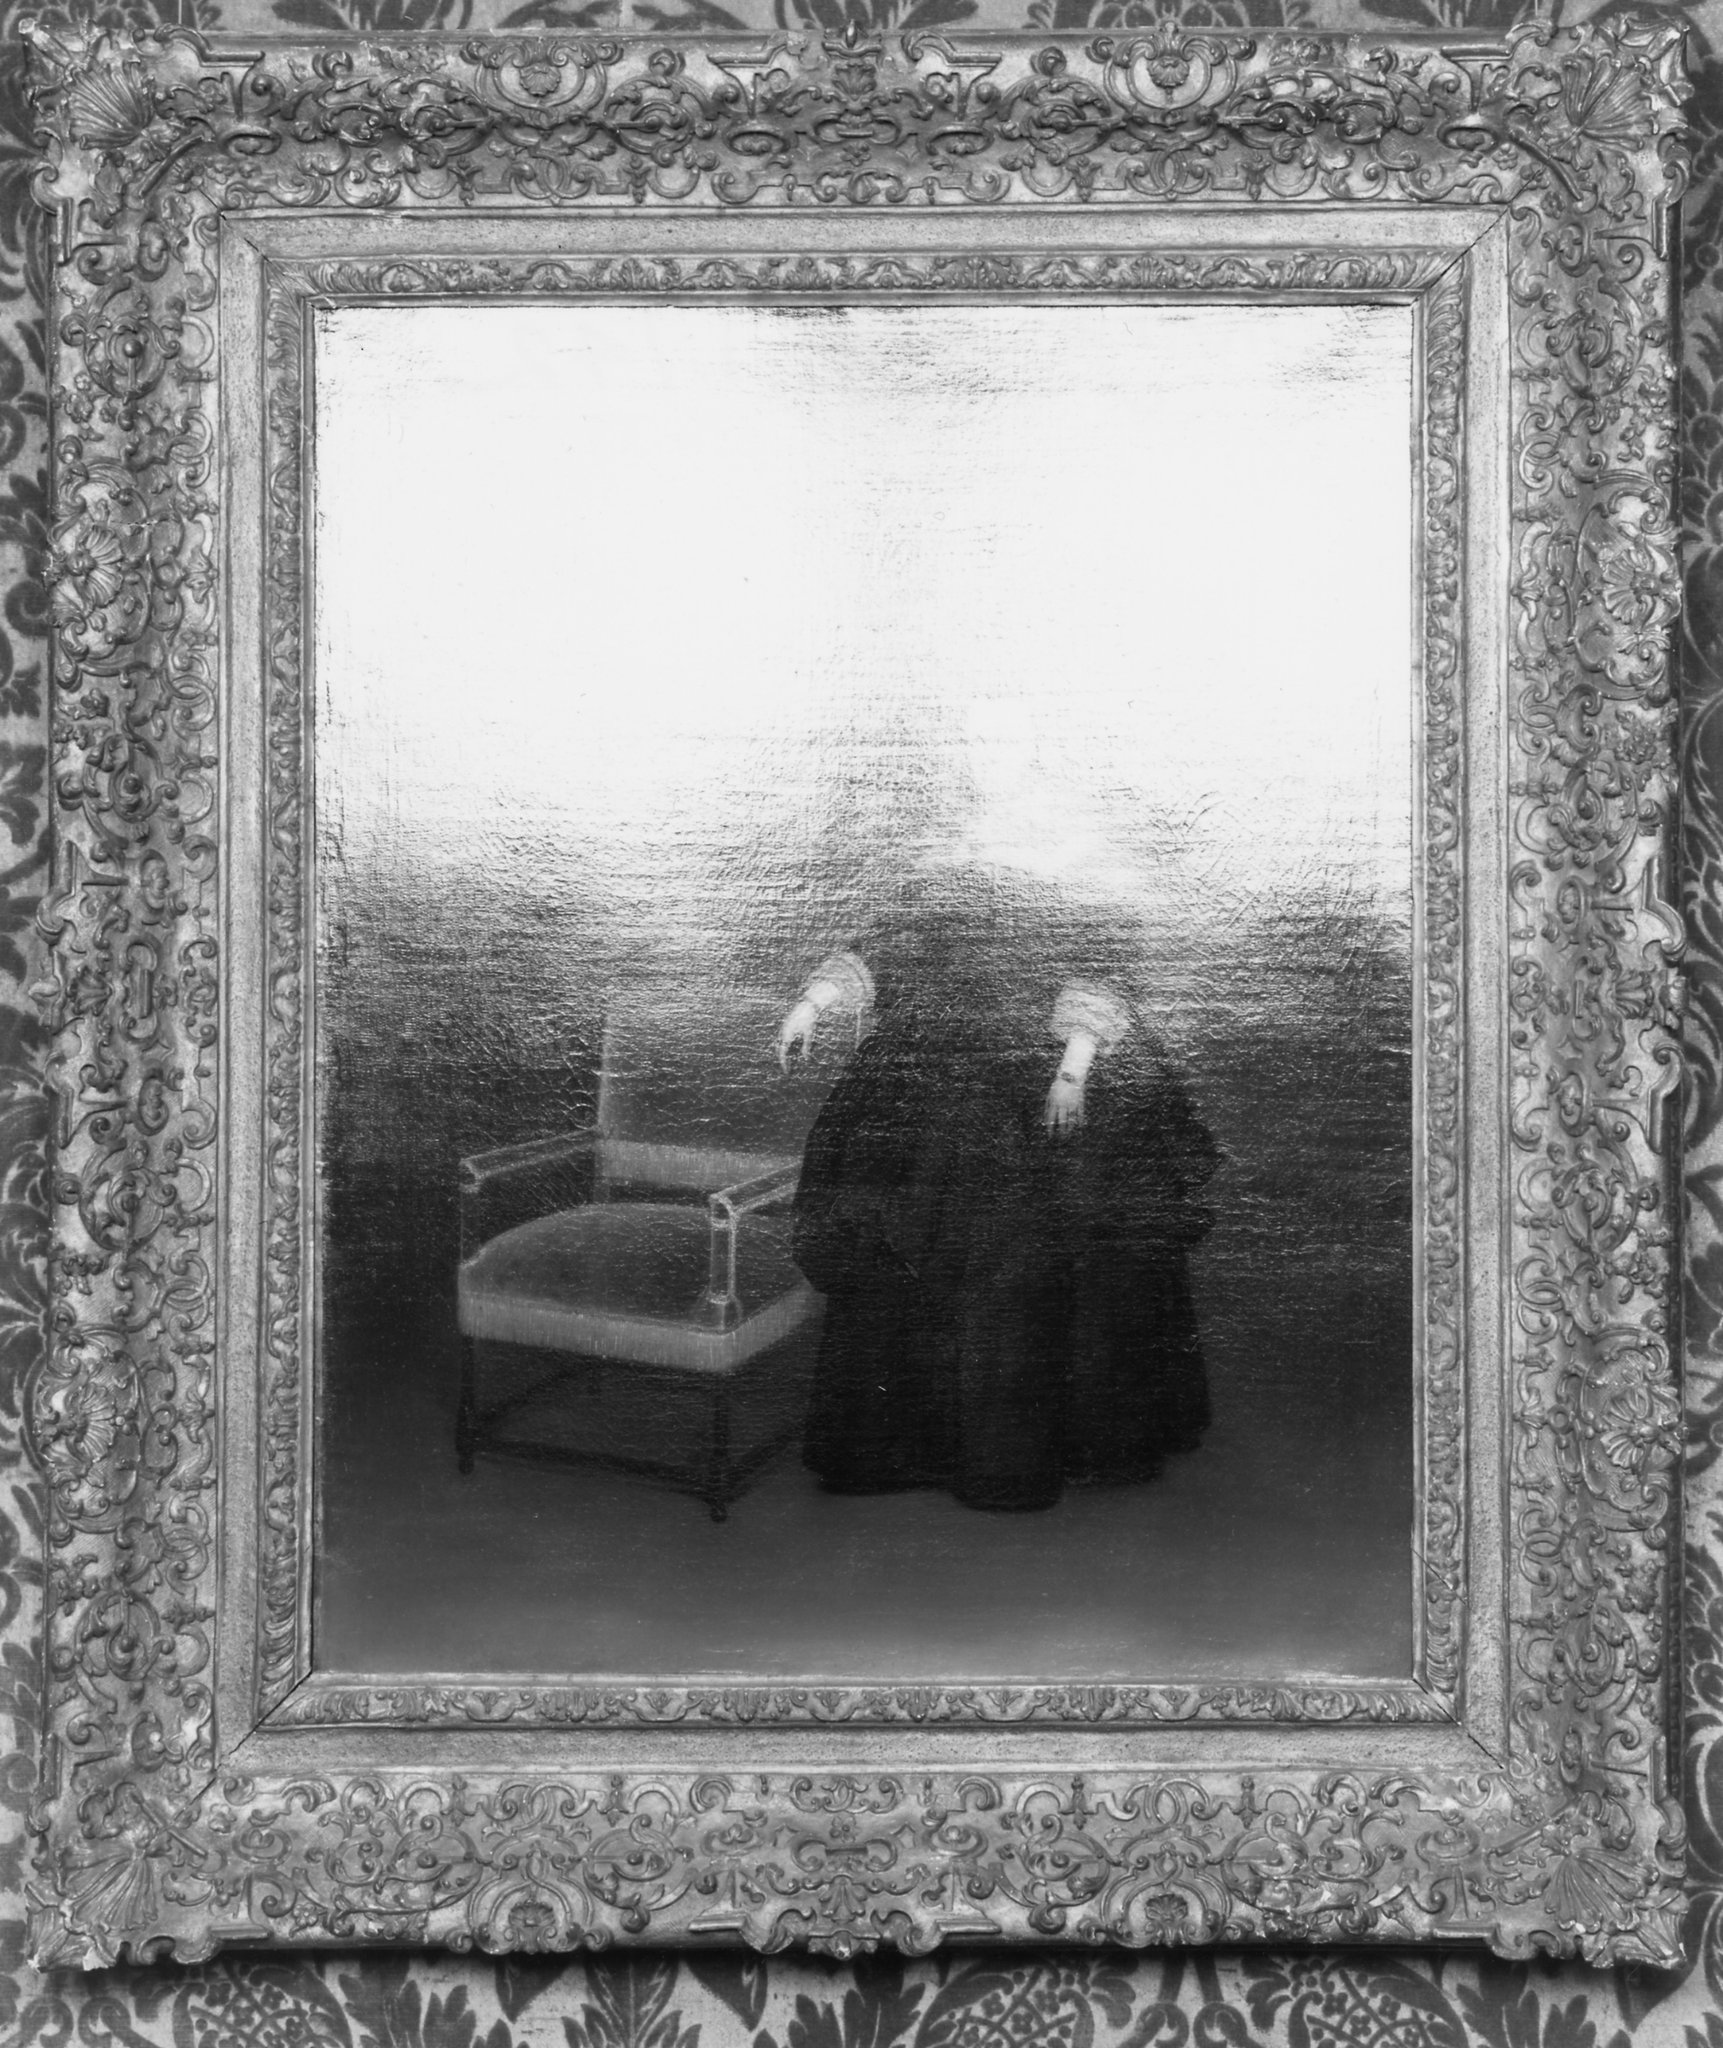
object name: frame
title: Late 17th-century style Ogee frame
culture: french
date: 1870-1880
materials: gilt, wood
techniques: carving